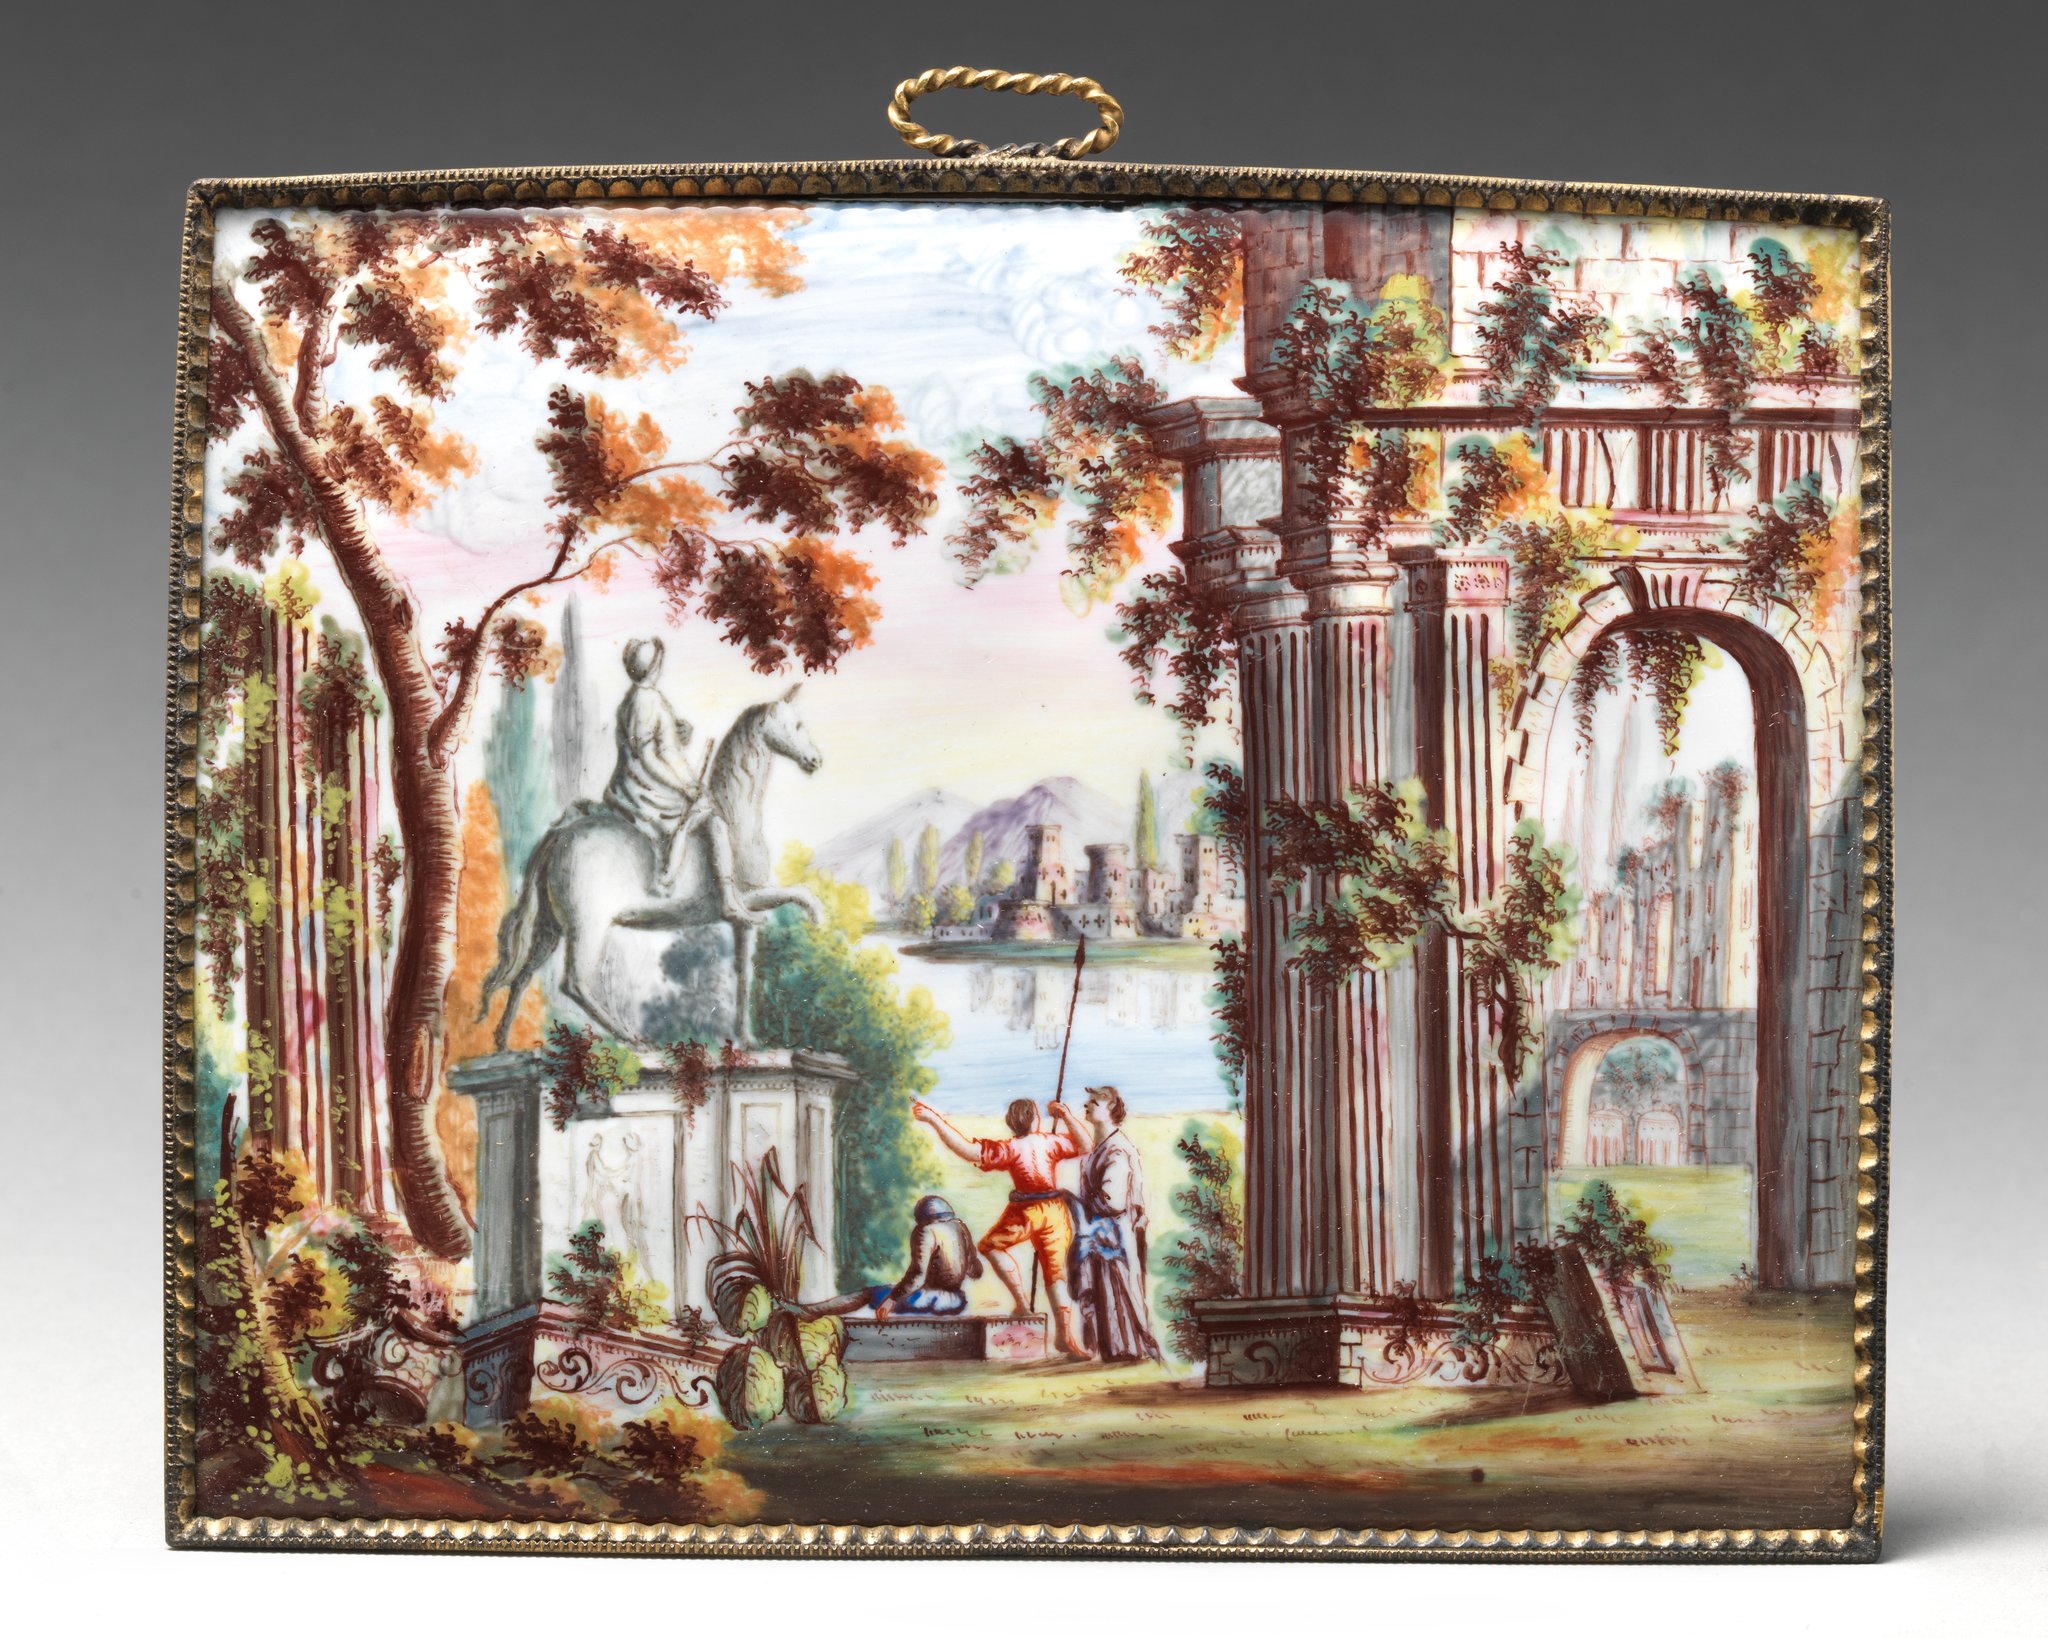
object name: plaque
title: Plaque with classical landscape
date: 1755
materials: copper, enamel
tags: human figures,animals,horses,trees